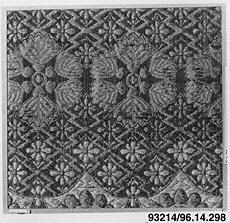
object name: piece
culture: japanese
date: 1701-1900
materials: silk